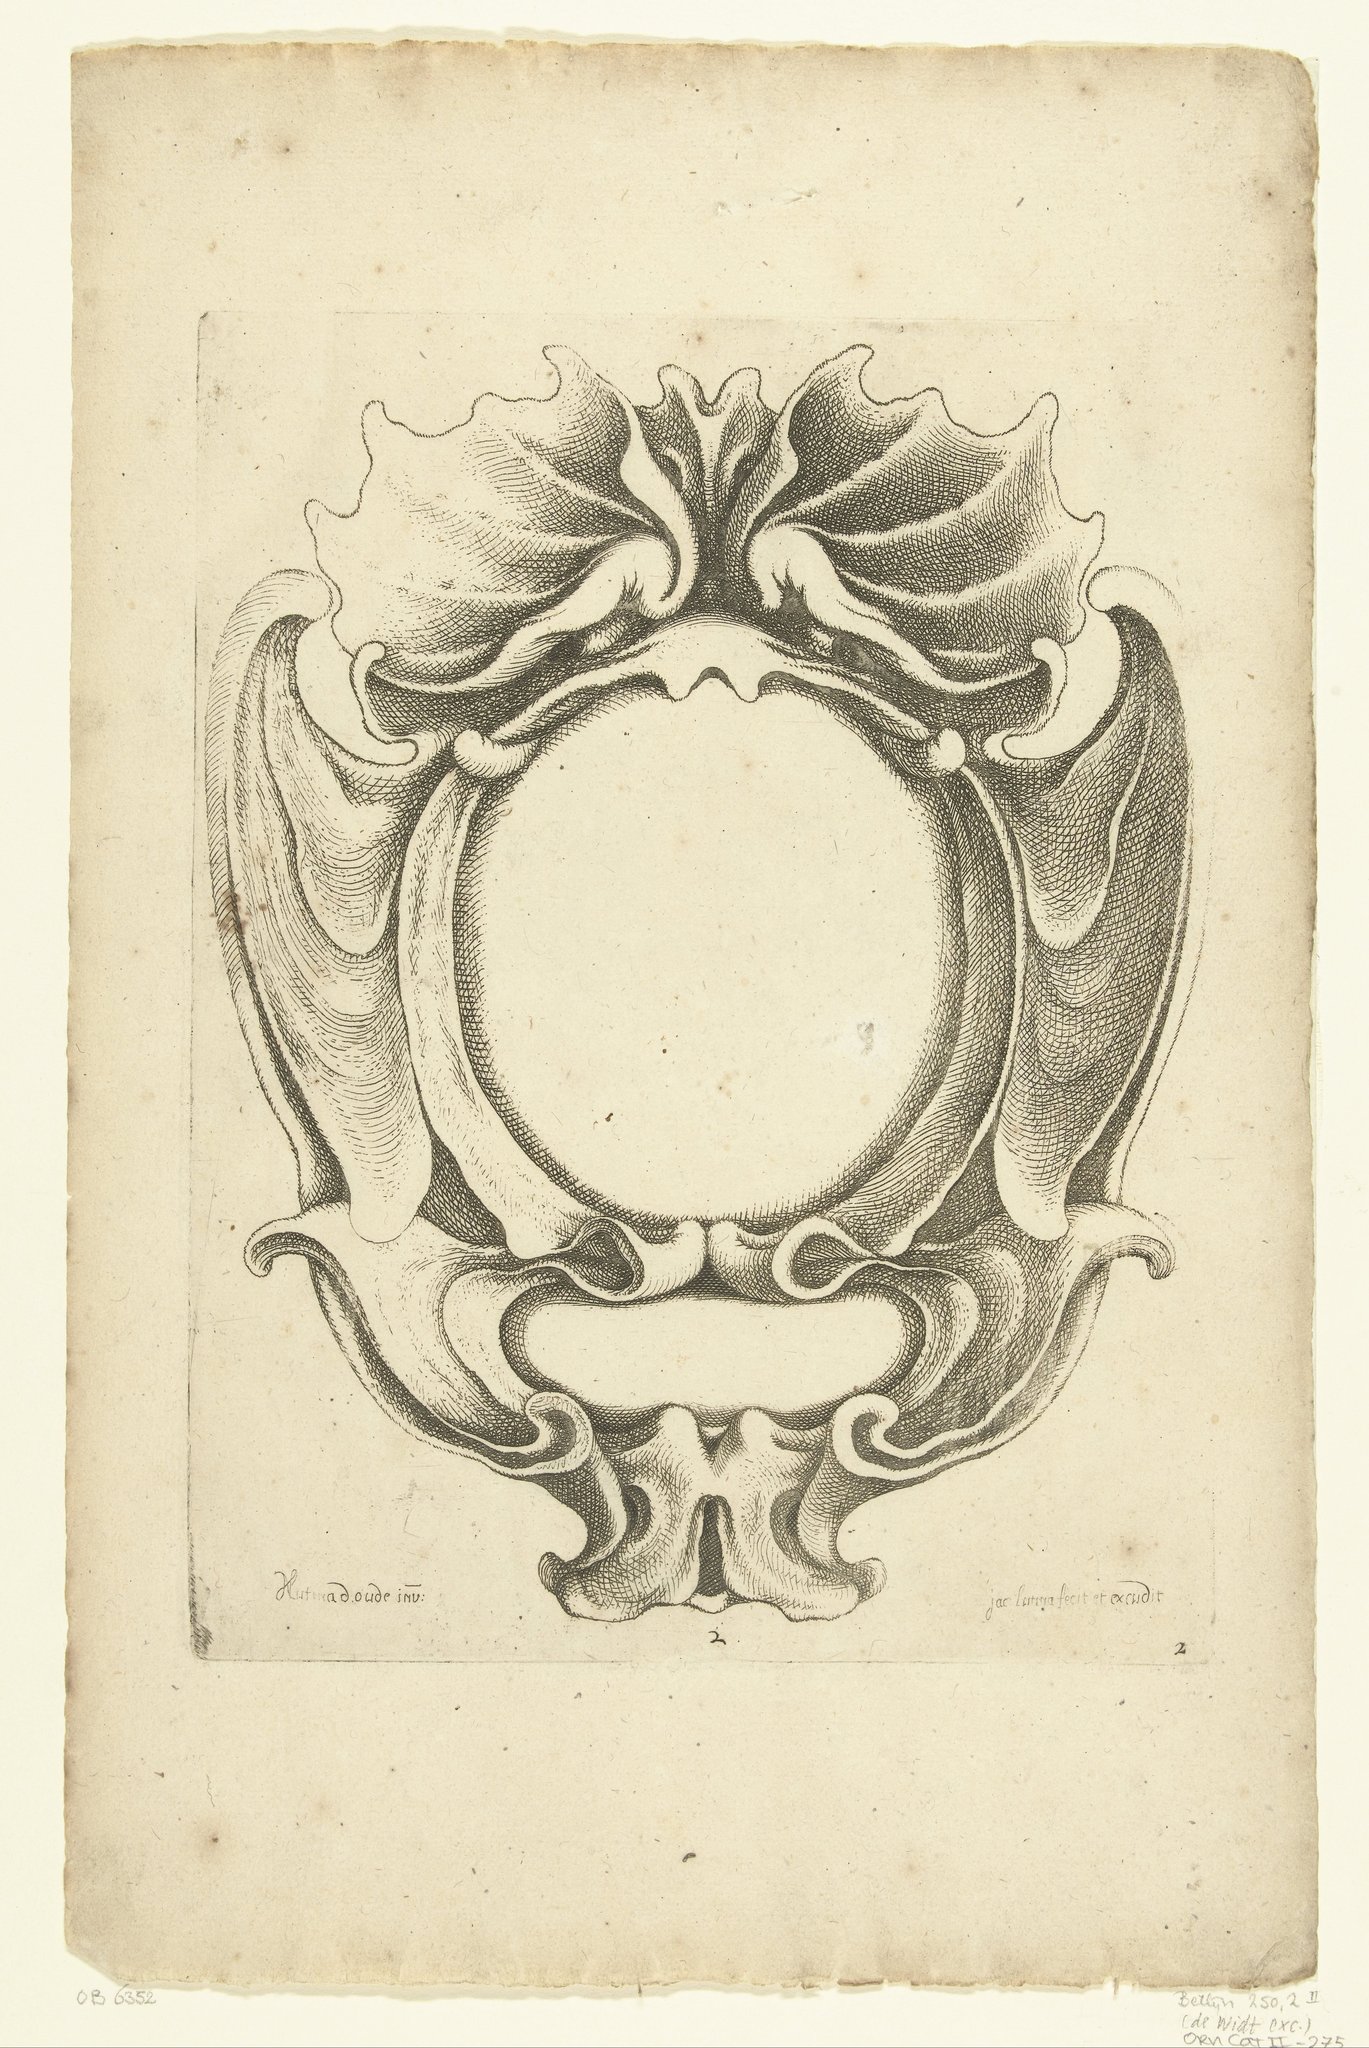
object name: print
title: Cartouche met een groot en klein compartiment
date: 1654-1678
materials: paper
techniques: etching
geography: amsterdam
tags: animals (+ wings of an animal), ornament ~ cartouche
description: Cartouche met vleugelachtige motieven aan de zijkanten en bovenaan twee vleermuisachtige vleugels.